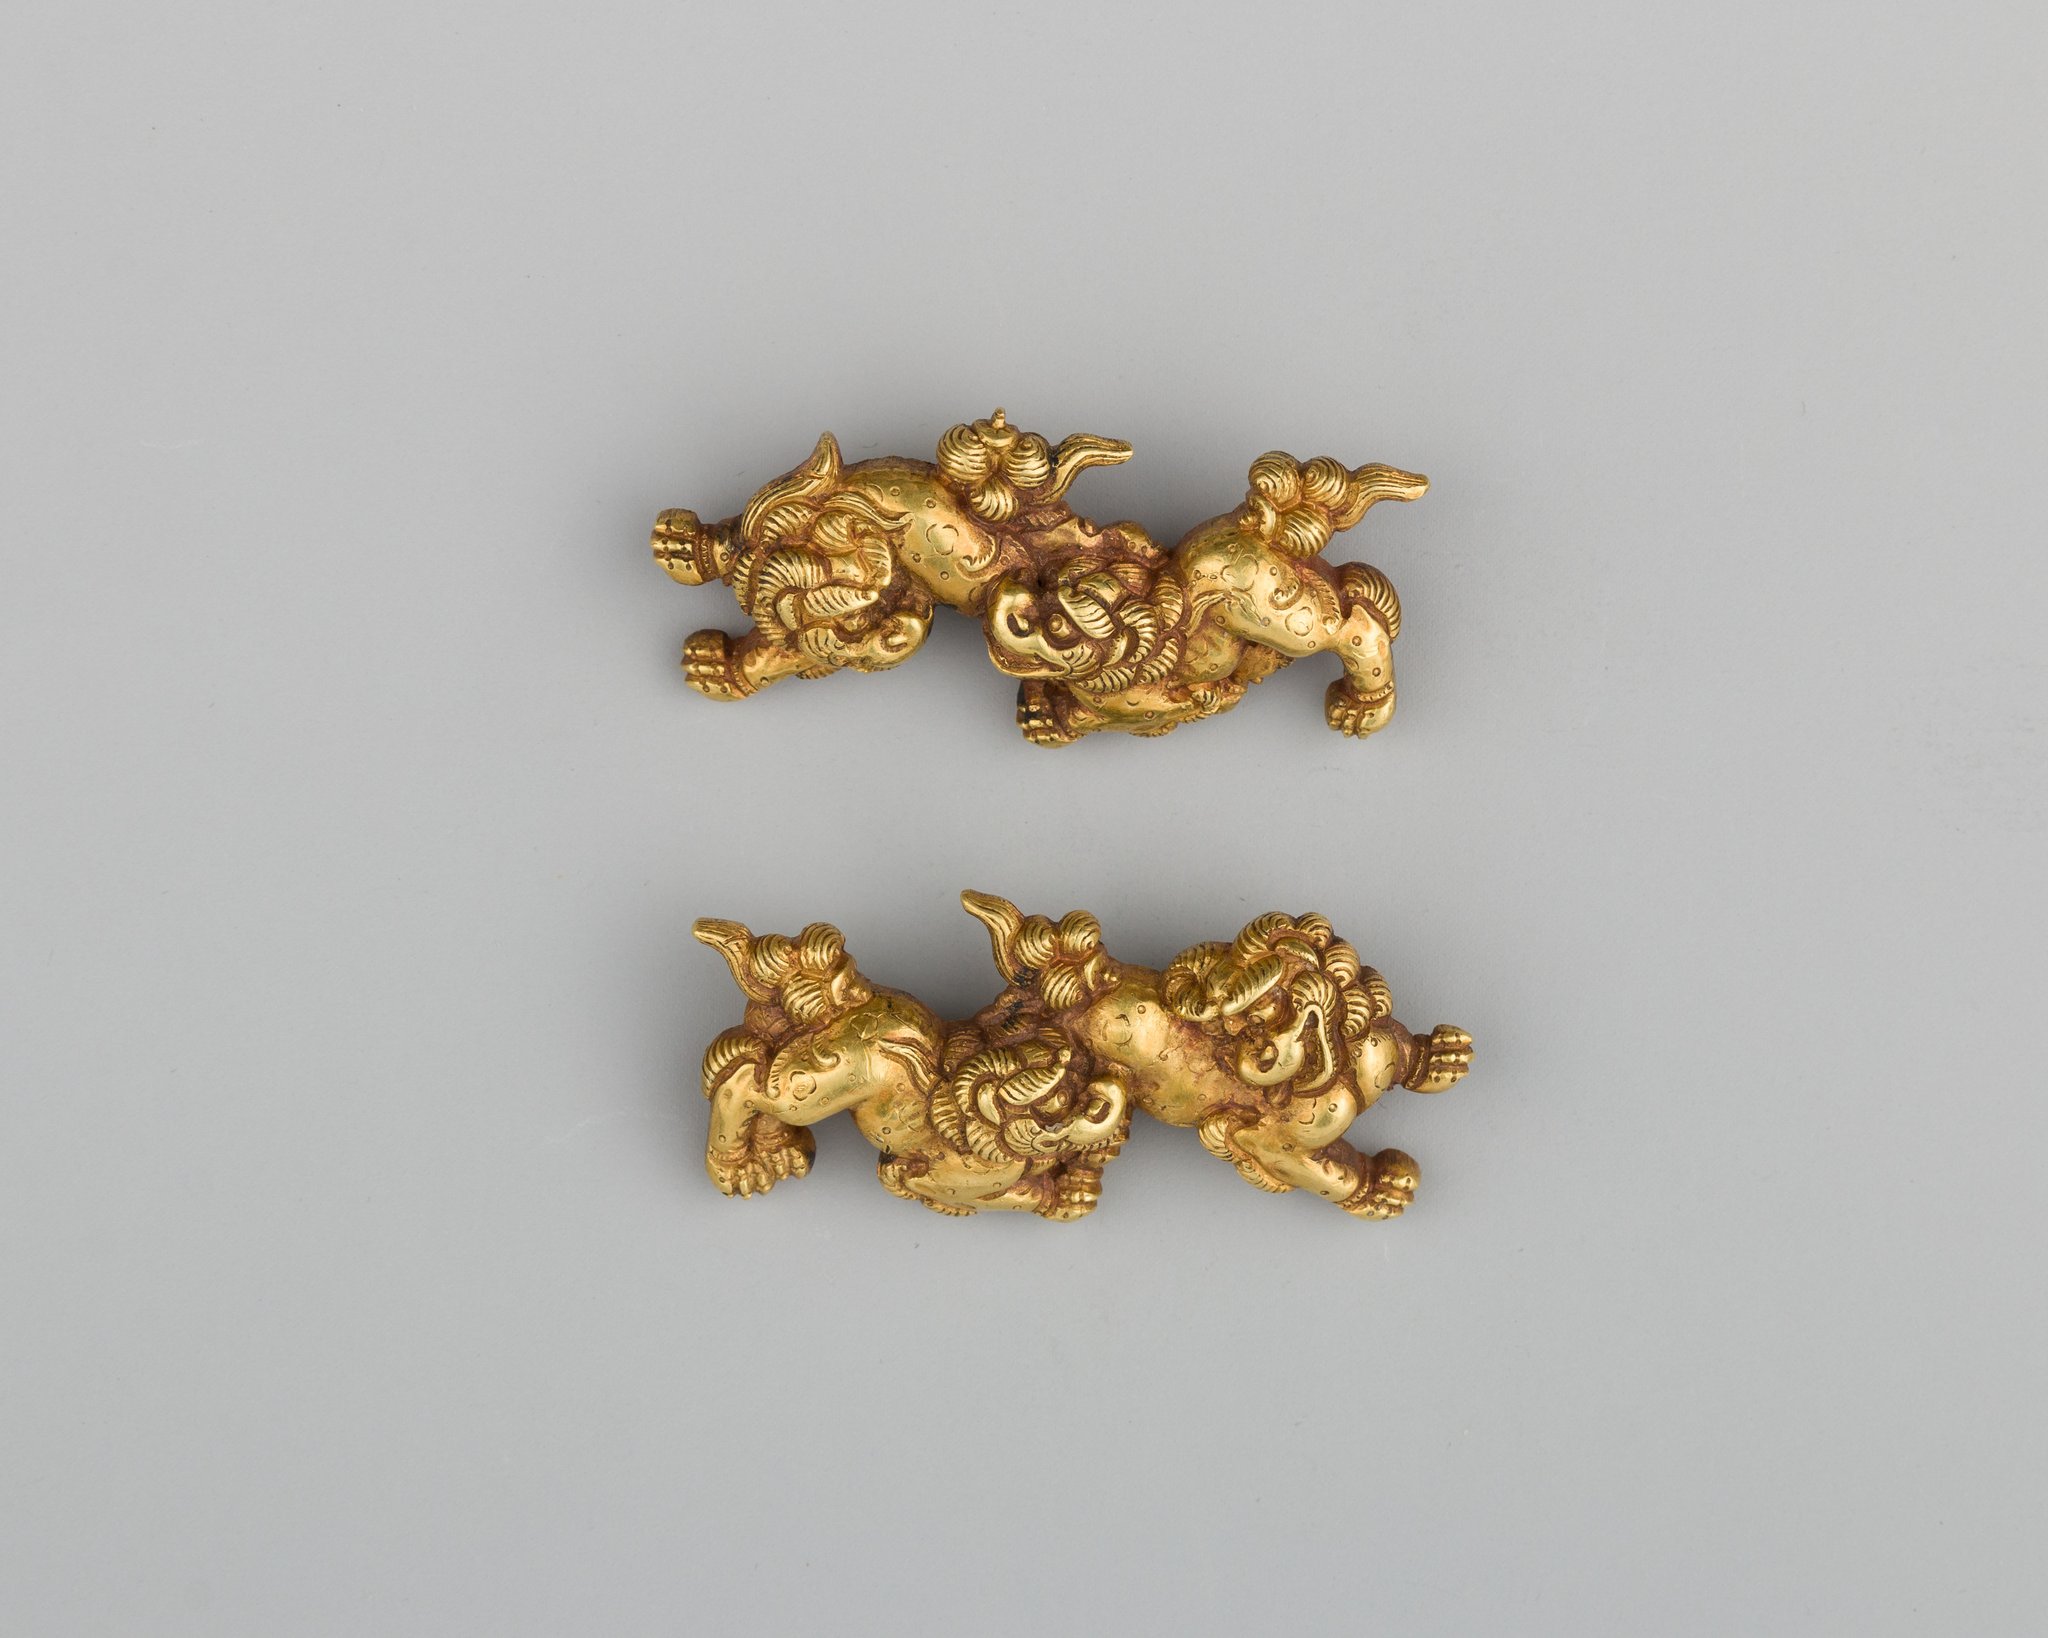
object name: pair of sword grip ornament menuki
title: Pair of Sword-Grip Ornaments (Menuki)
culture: japanese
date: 1701-1800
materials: gold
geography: japan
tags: lions